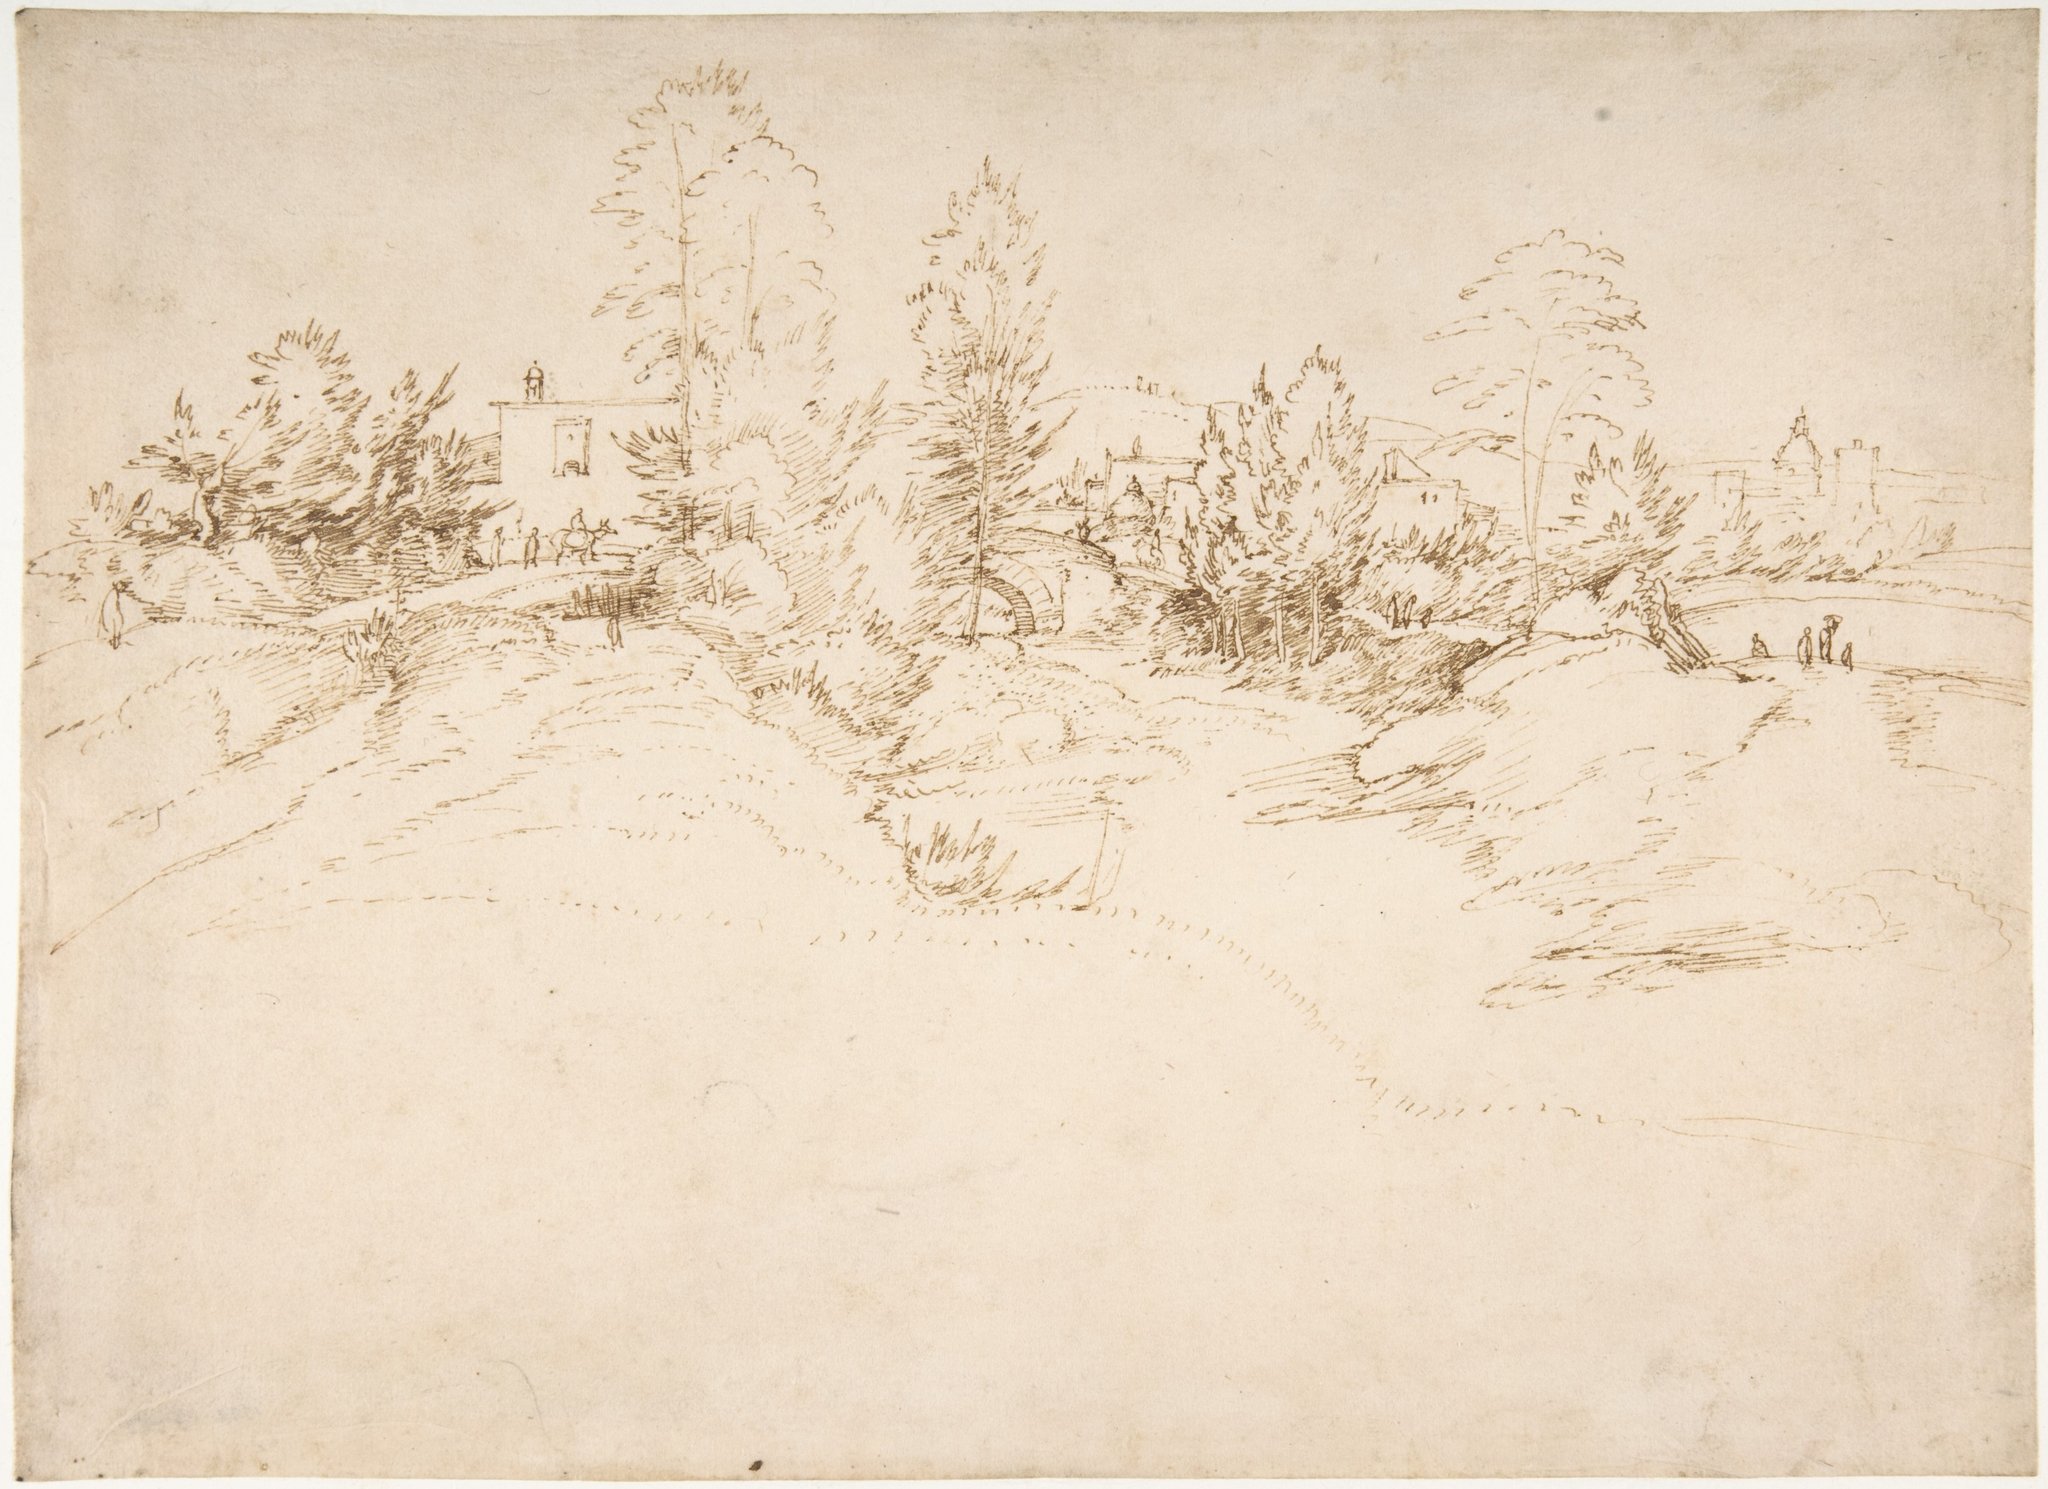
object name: drawing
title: Landscape (Wooded Approach to a Town)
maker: fra bartolomeo (bartolomeo di paolo del fattorino)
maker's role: artist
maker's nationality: italian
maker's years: 1473-1517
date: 1508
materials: ink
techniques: pen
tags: houses,landscapes,trees